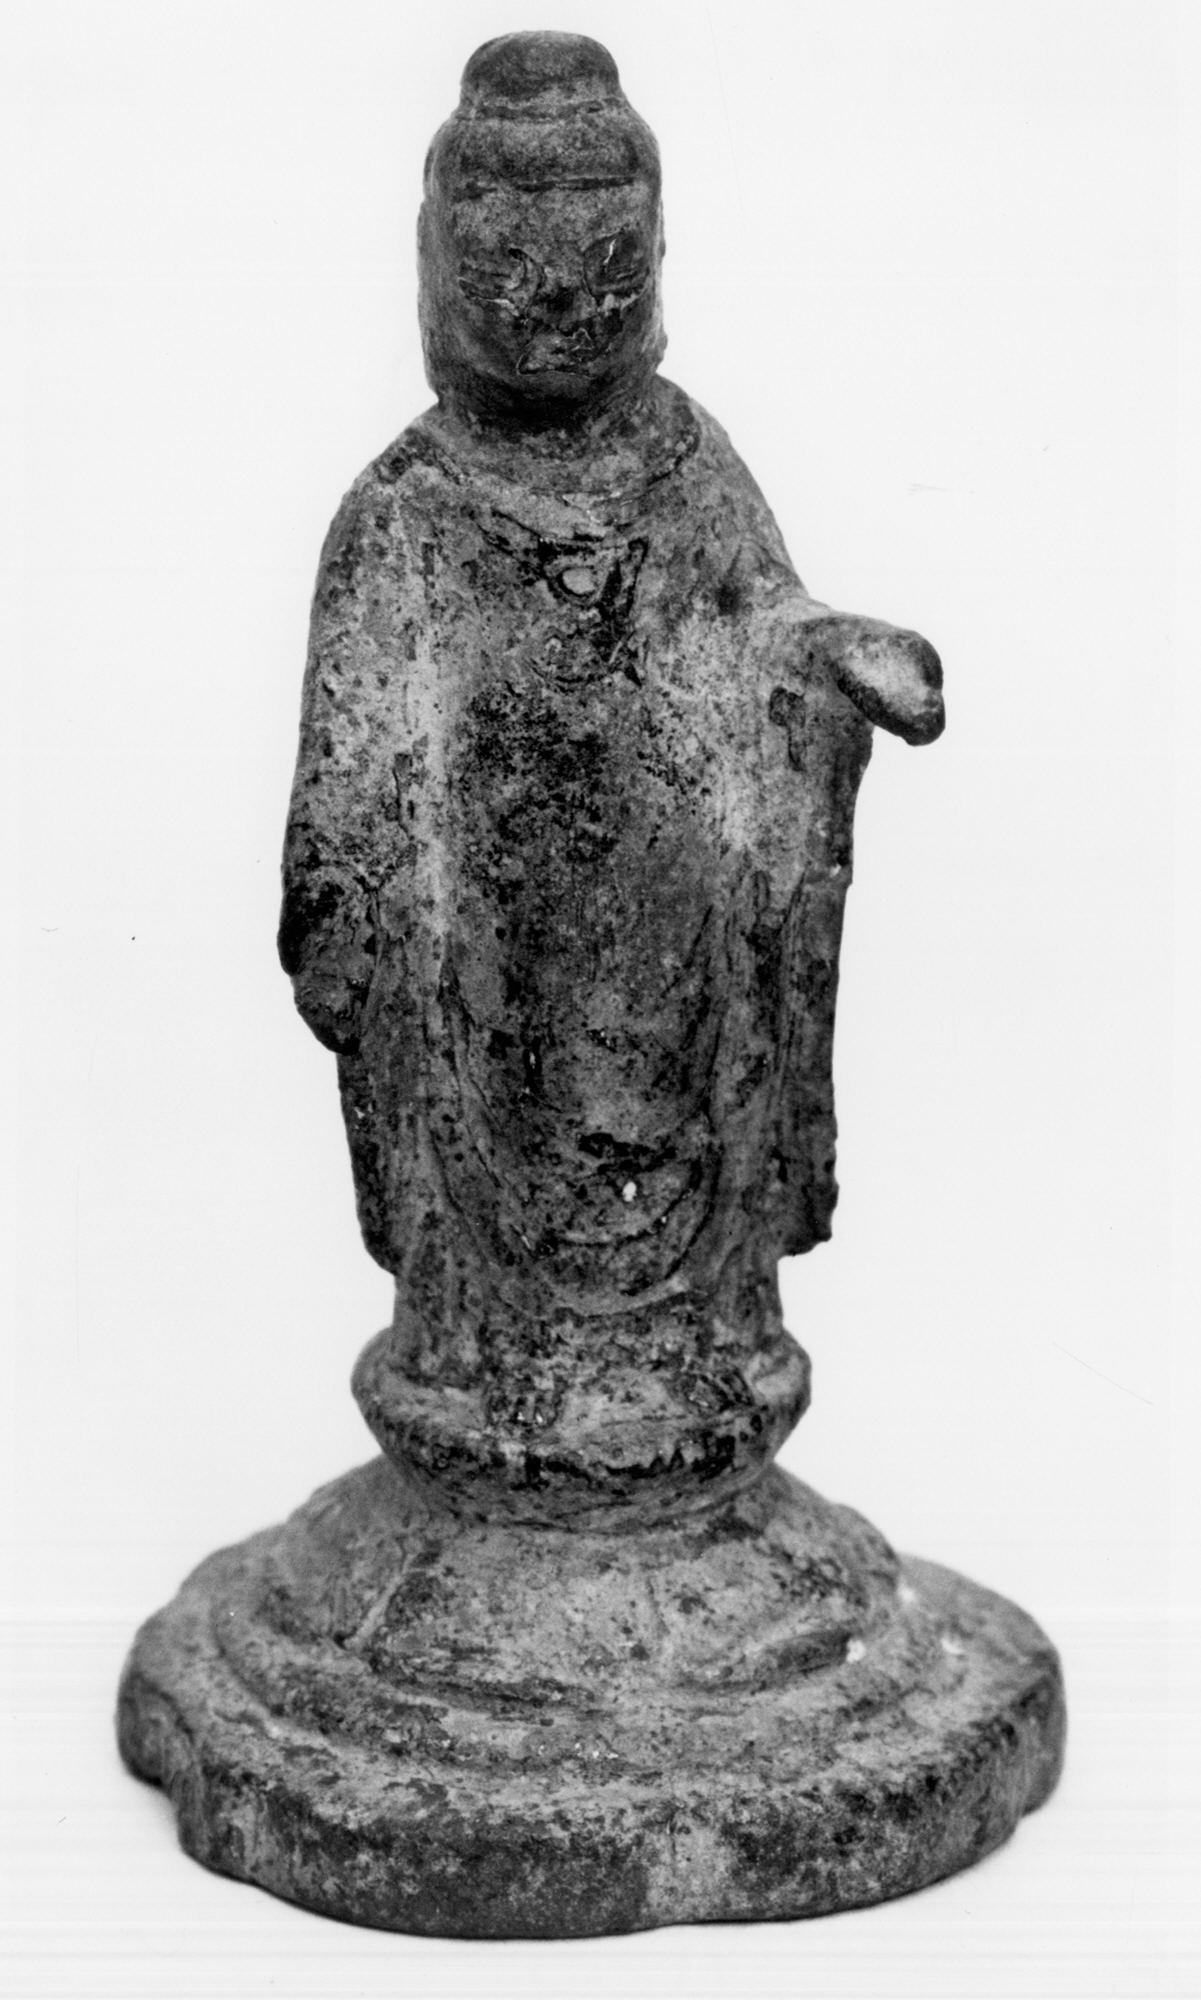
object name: statuette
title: Buddha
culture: korean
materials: bronze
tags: buddhism,buddha